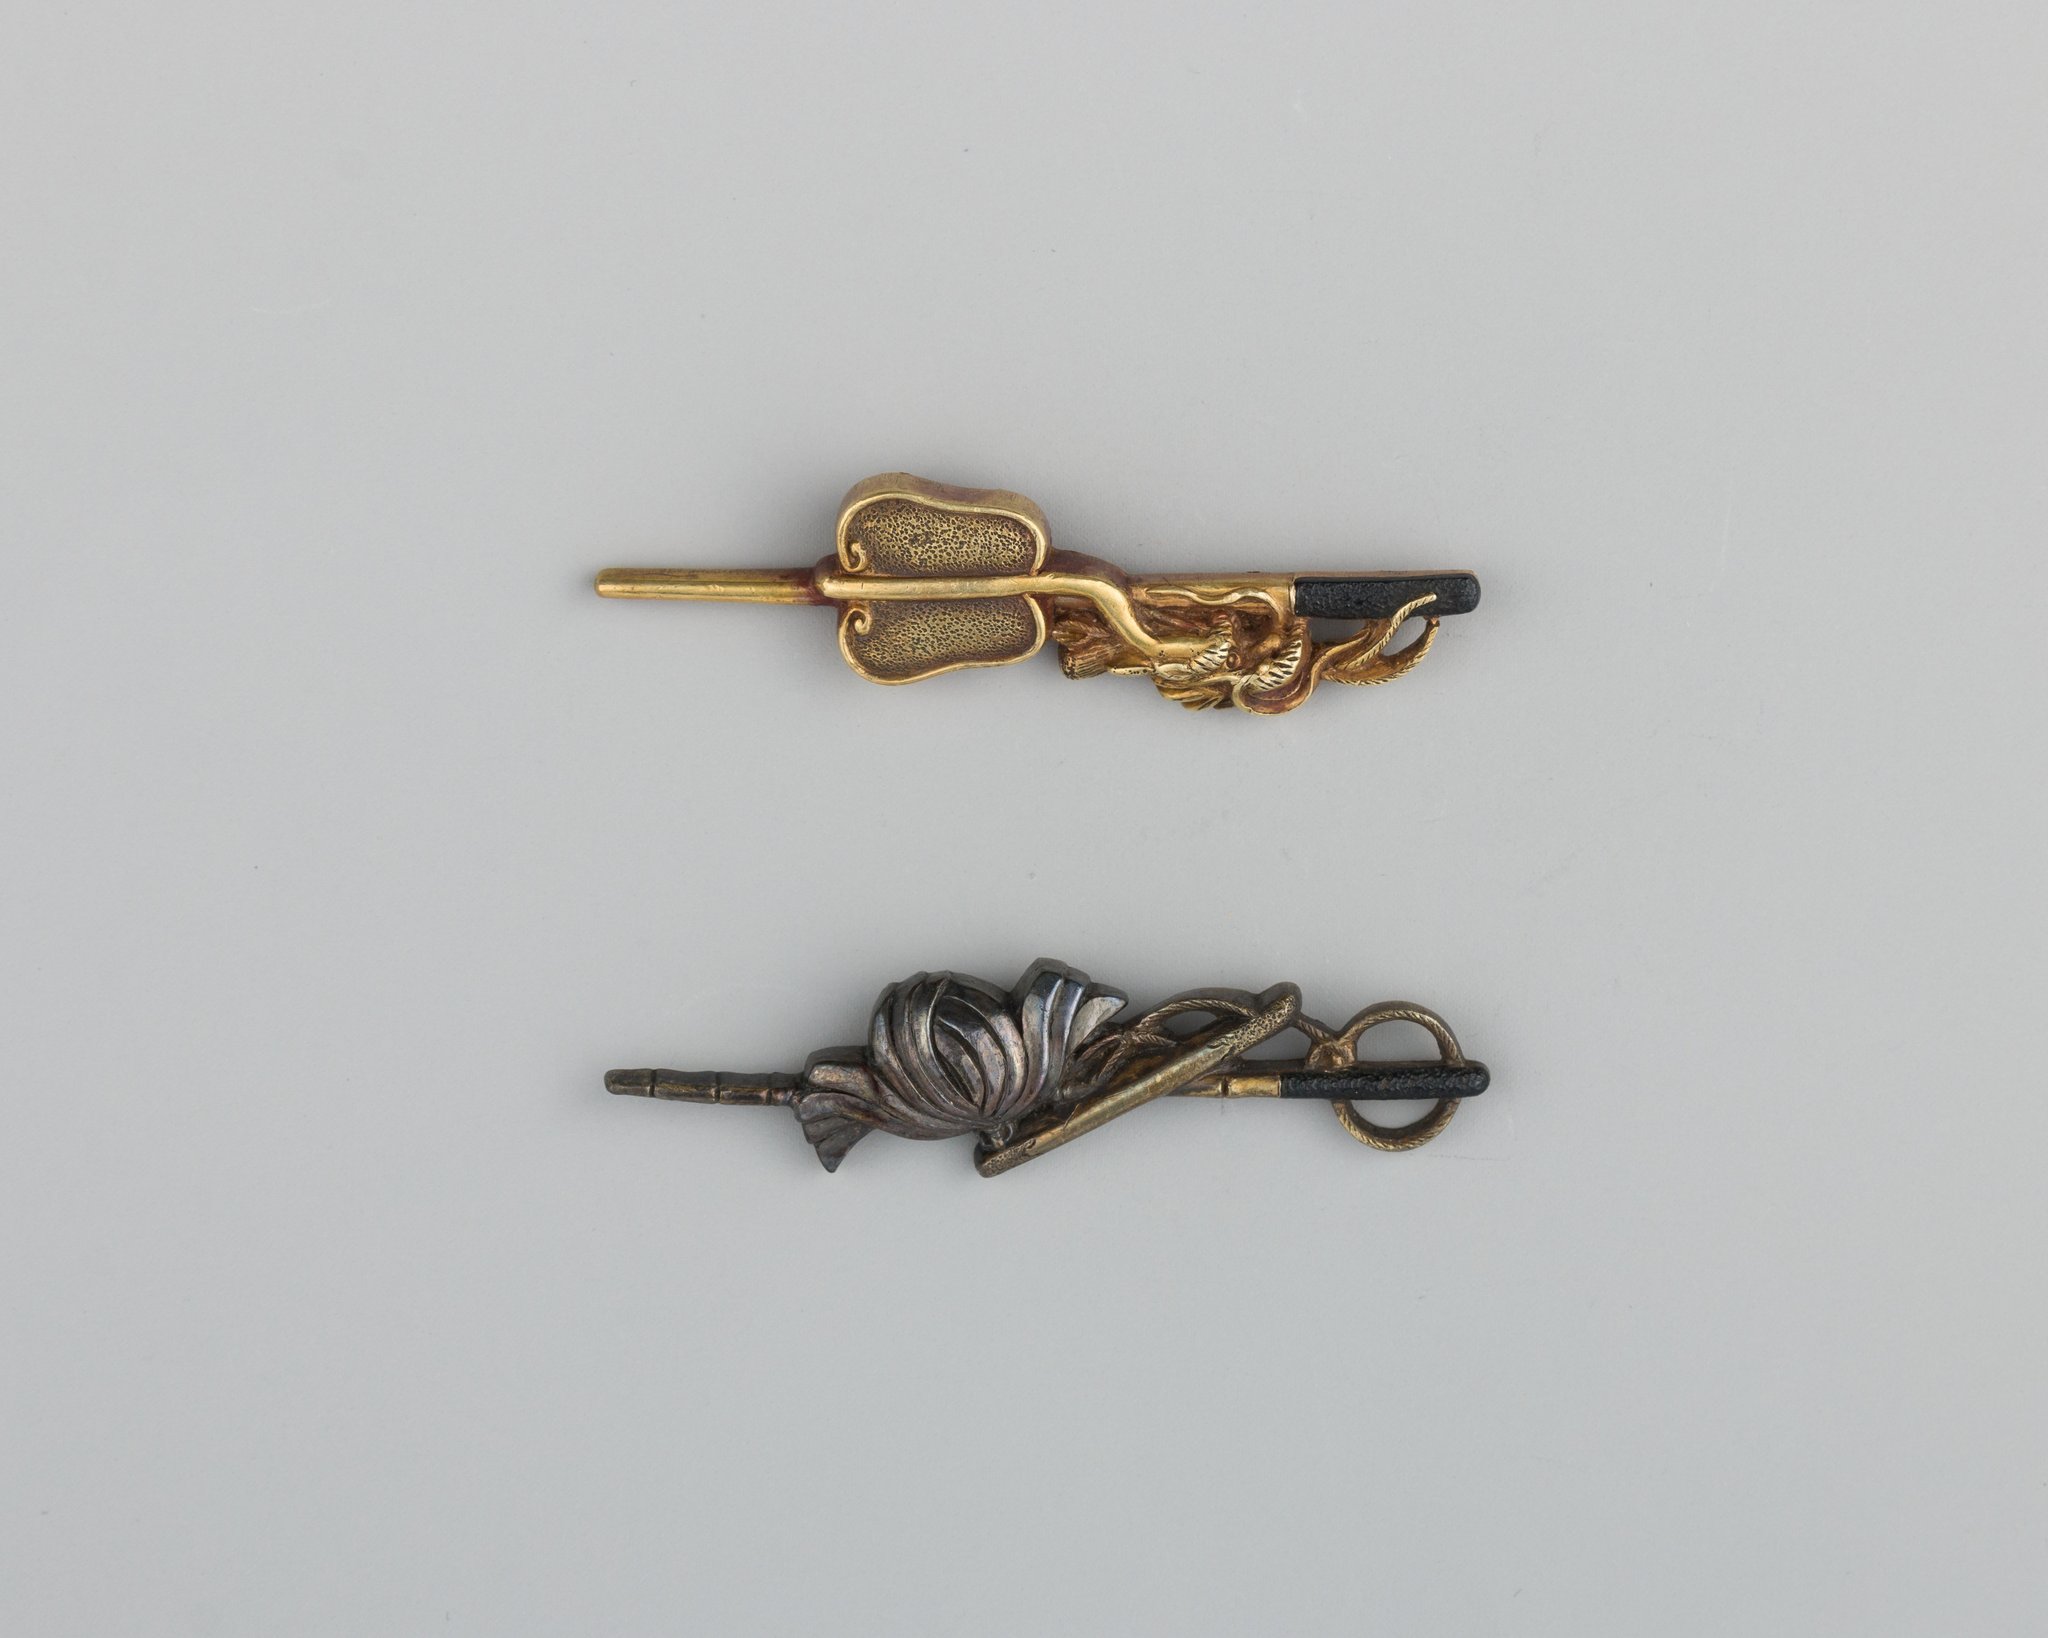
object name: pair of sword grip ornament menuki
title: Pair of Sword-Grip Ornaments (Menuki)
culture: japanese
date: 1701-1800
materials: gold alloy, gold, silver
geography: japan